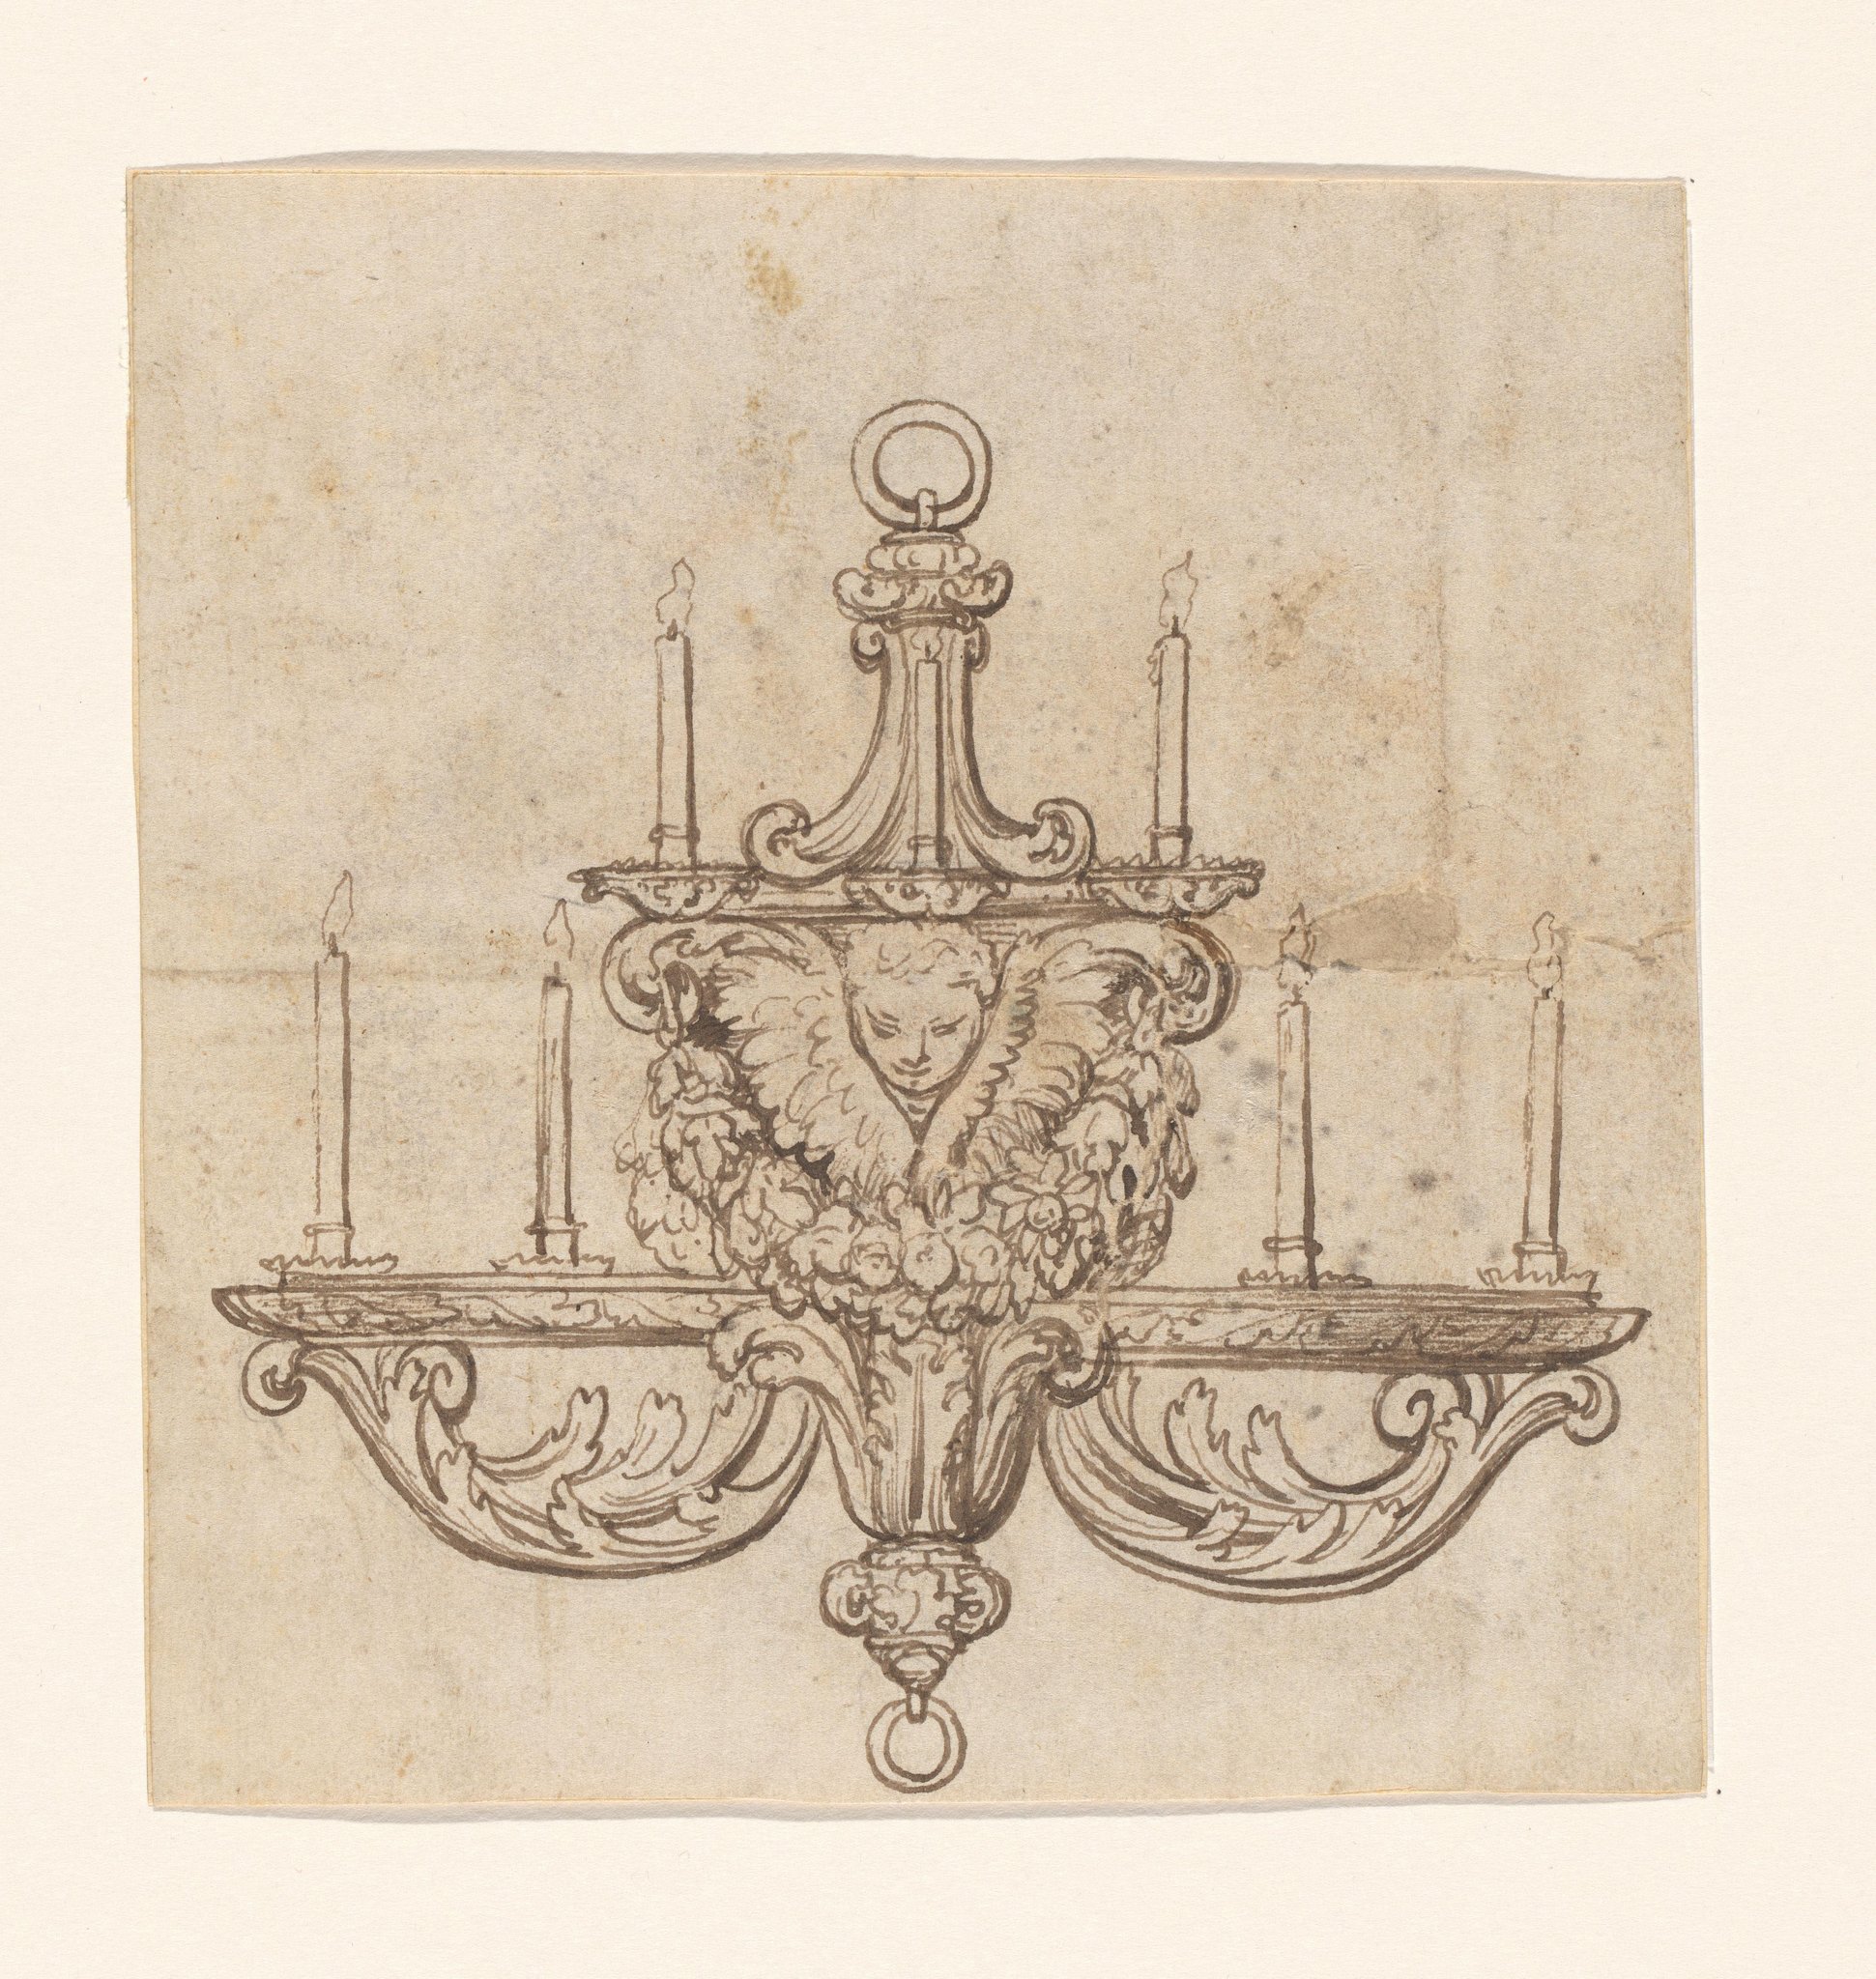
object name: design drawing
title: Een lichtkroon of wandarm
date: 1700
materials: graphite, ink, paper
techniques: pen